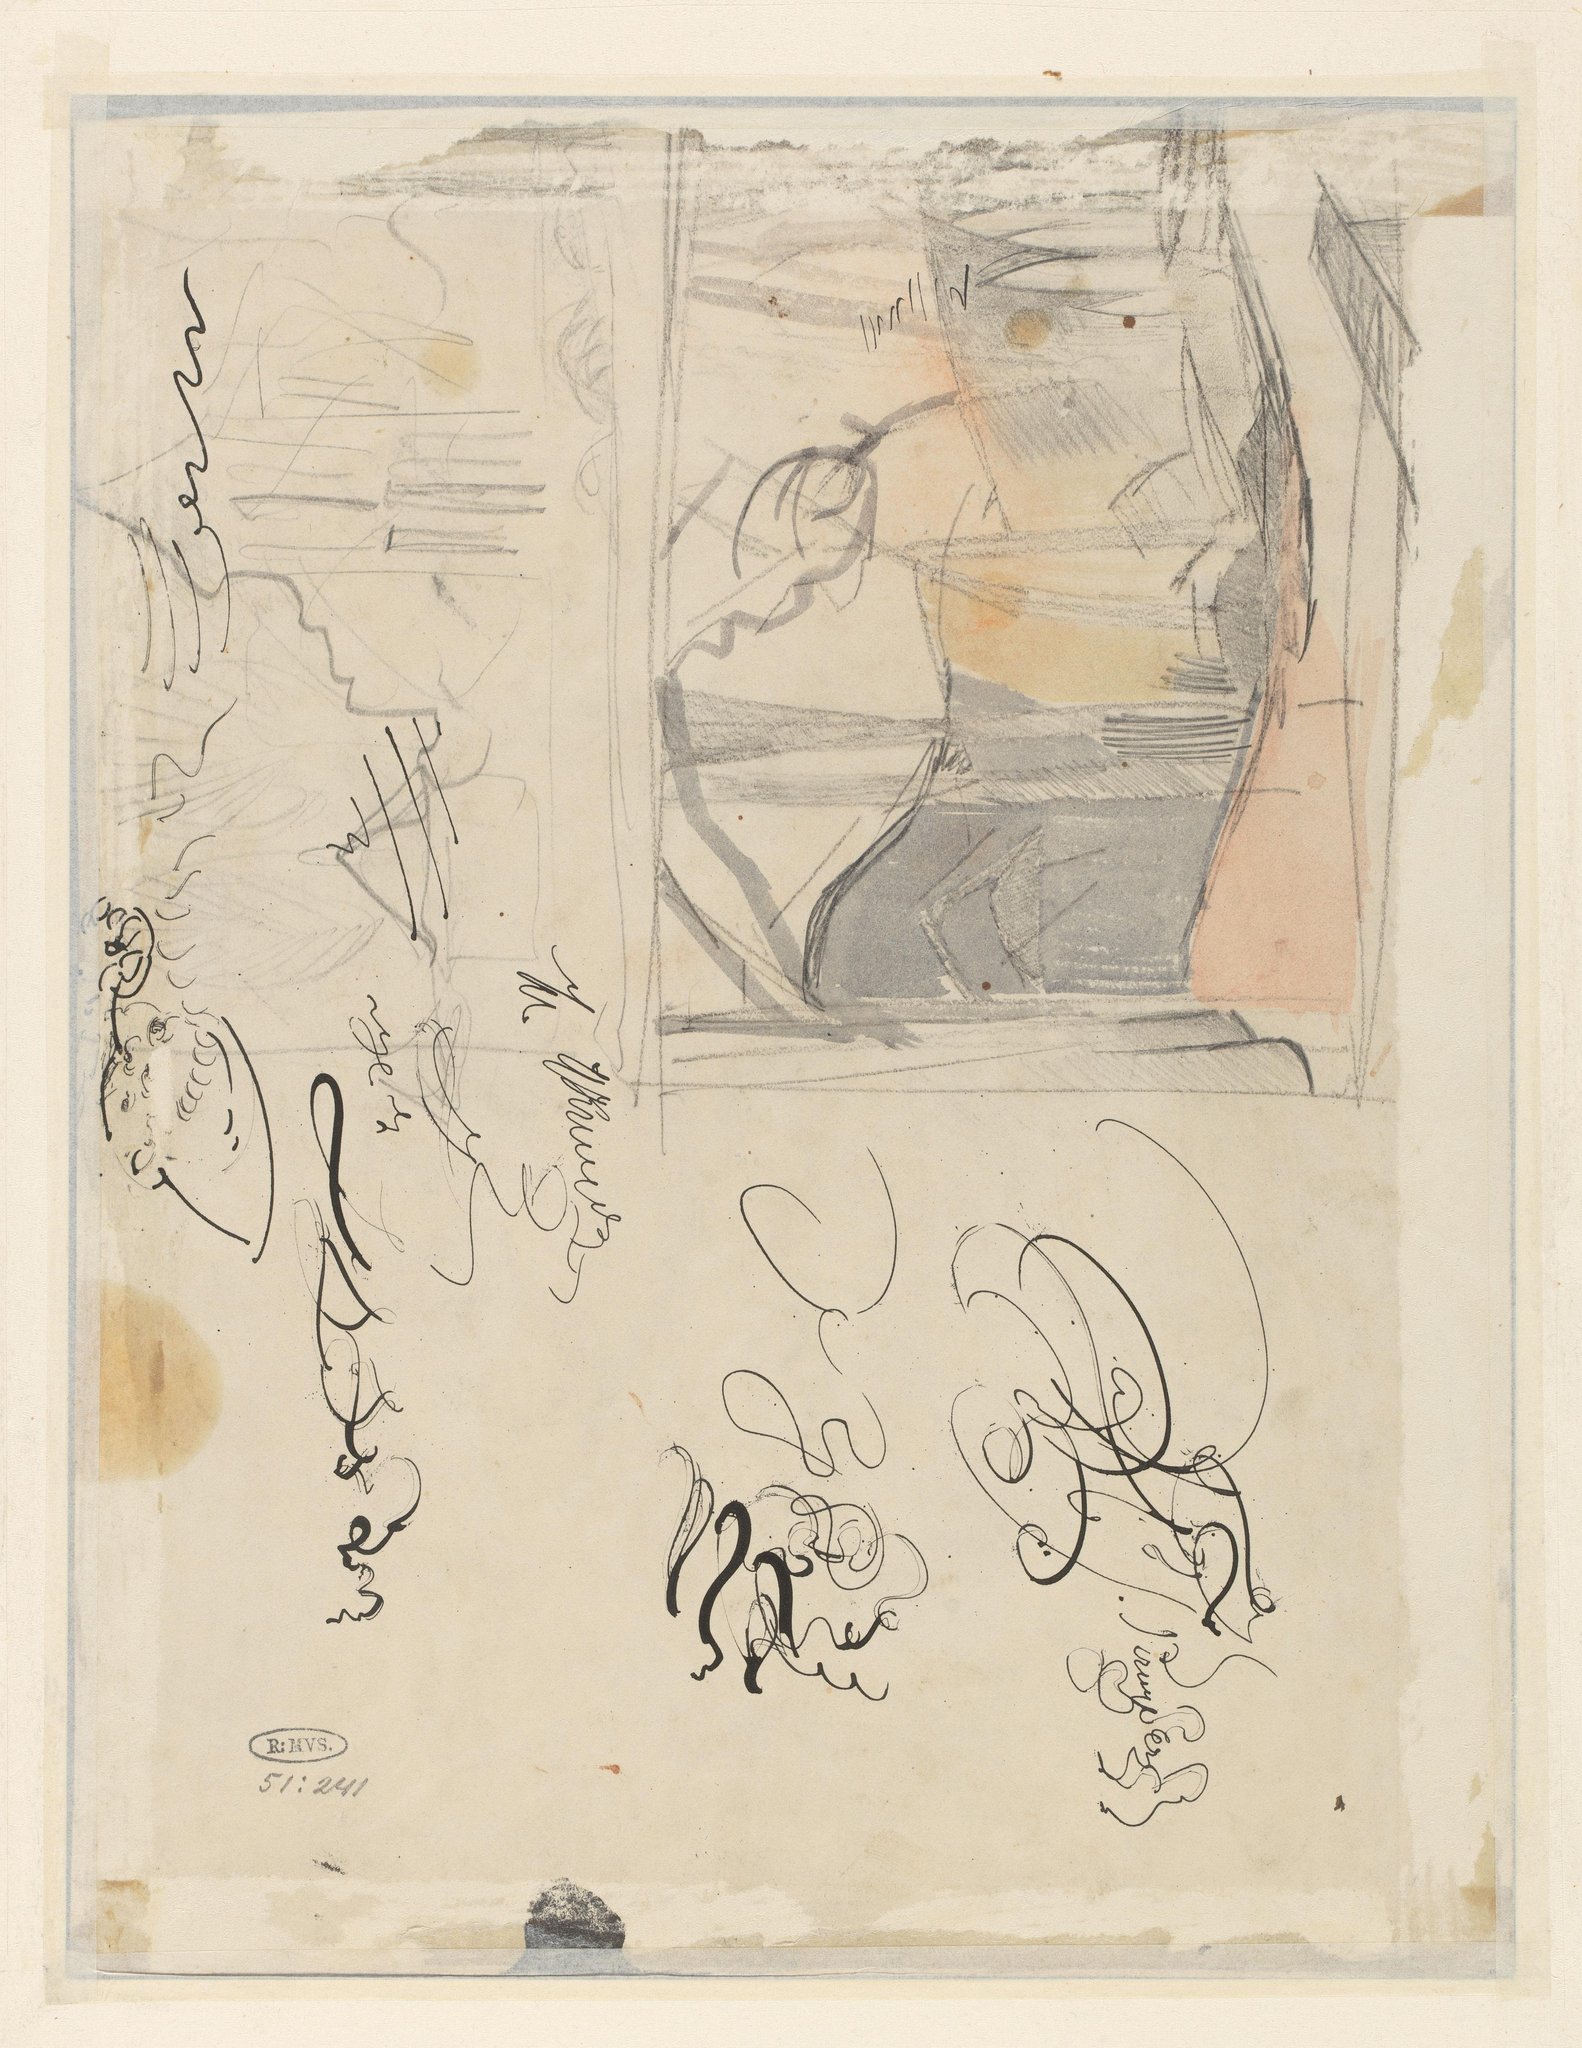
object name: drawing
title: Studieblad met landschap, omtrek van een gebouw, een gezicht en krabbels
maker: herman kruyder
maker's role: draughtsman, print maker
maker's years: 1881-1935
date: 1891-1935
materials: ink, paper, pencil, watercolor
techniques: brush, pen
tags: face, landscapes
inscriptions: collector's mark: Lugt 2228